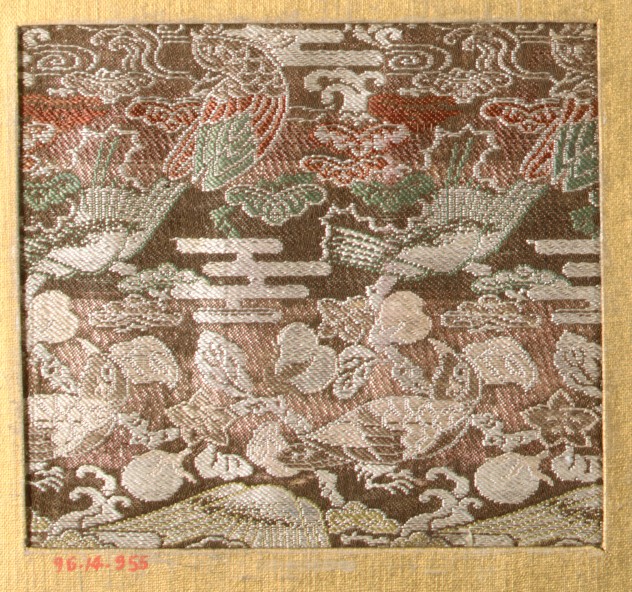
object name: piece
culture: japanese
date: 1701-1900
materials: silk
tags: leaves